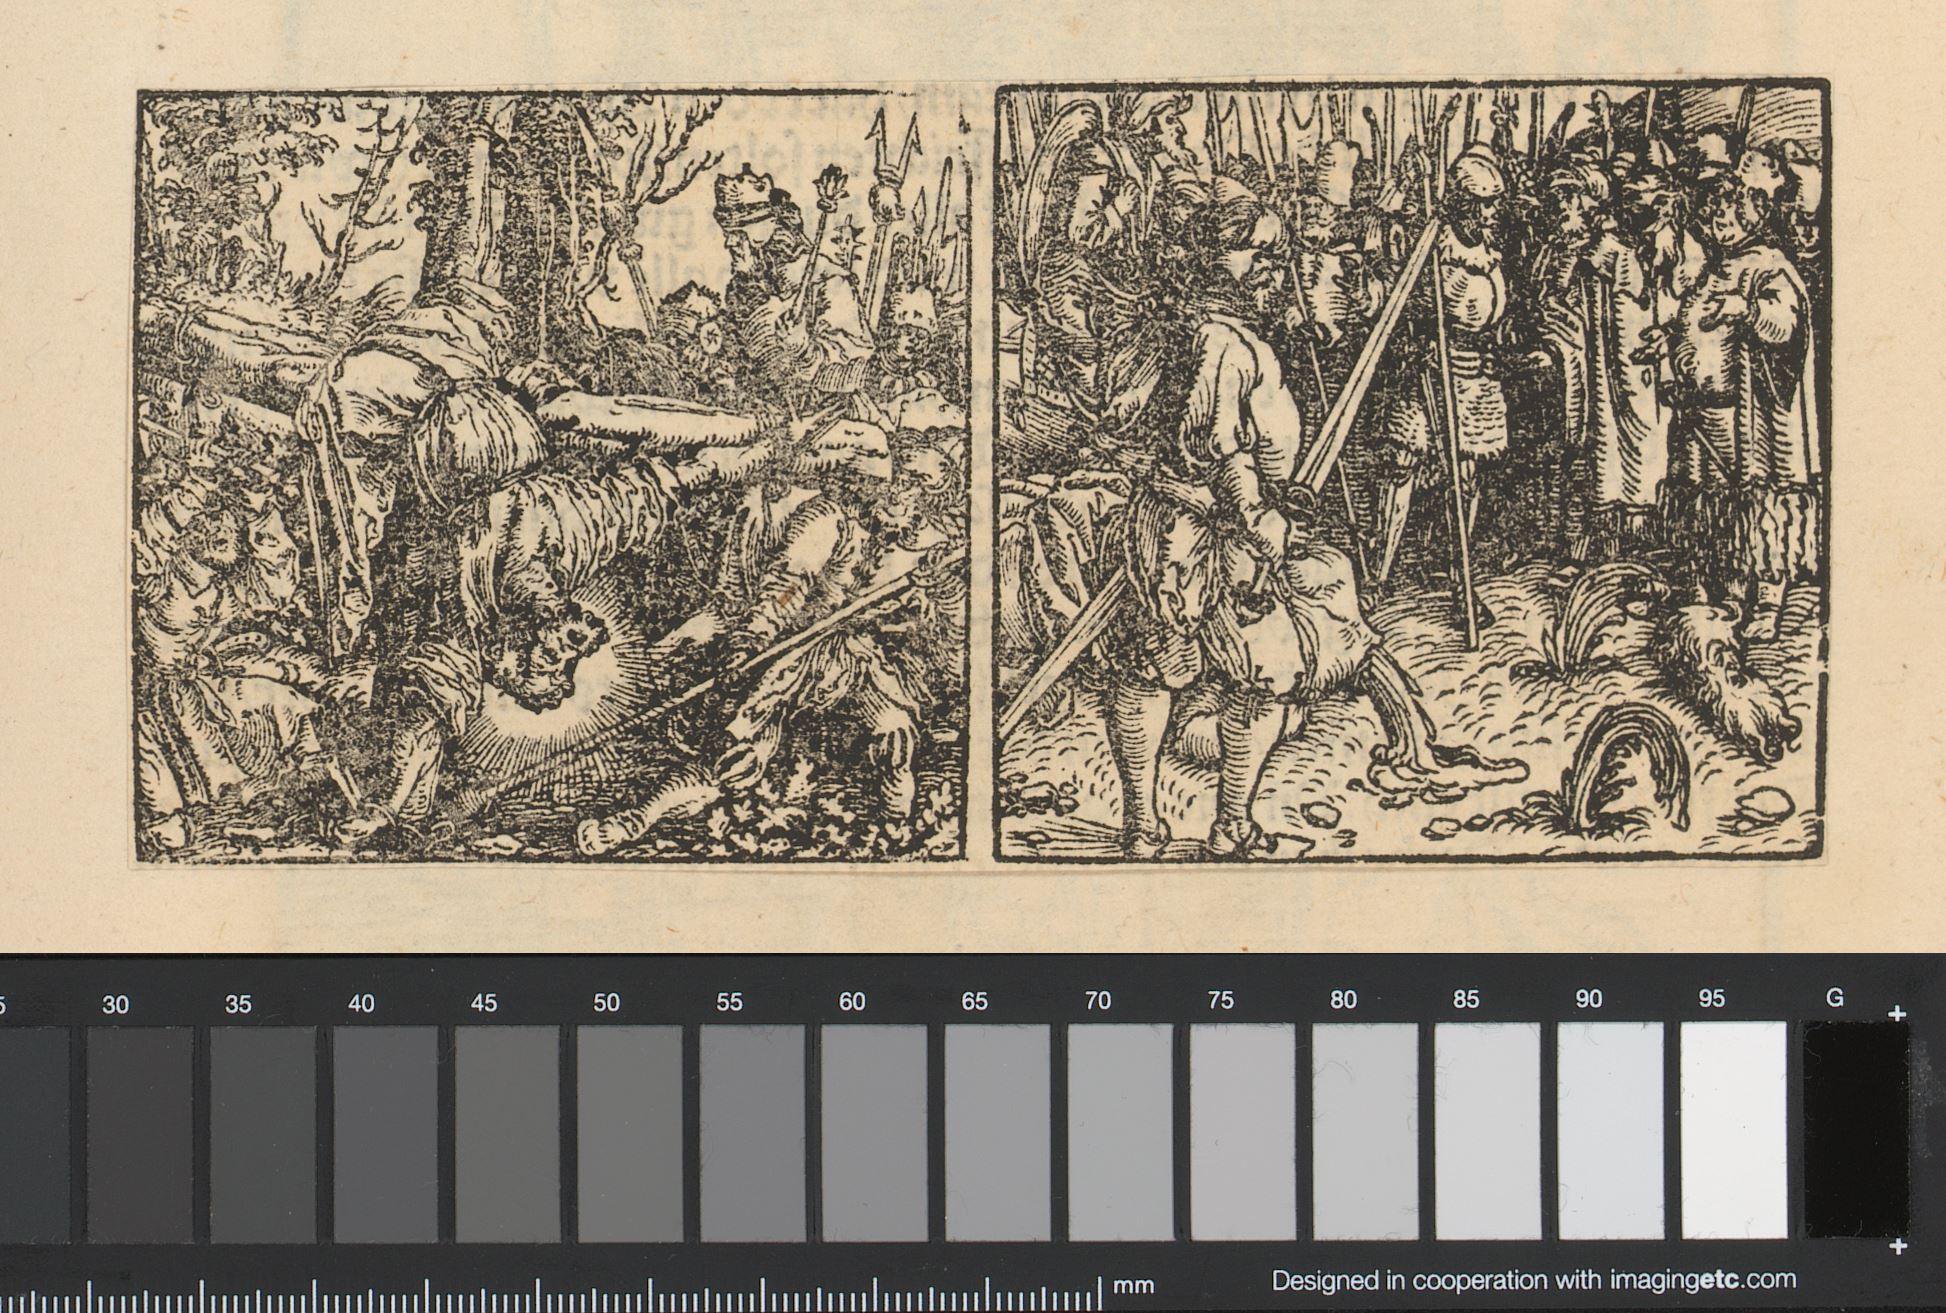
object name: album leaf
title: Kruisiging van Petrus en voorstelling van de onthoofding van de apostel Paulus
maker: Anonymous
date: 1514-1532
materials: paper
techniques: letterpress printing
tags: peter crucified upside down, the beheading of paul; maybe three fountains spring from his head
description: Deze prent is gebruikt in: Petrarca, Francesco. Von der Artzney bayder Glück, des guten und widerwertigen: unnd weß sich ain yeder inn Gelück und Unglück halten sol (...). Augsburg: Heinrich Steiner, 1532. Deze uitgave is ook bekend onder de titel 'Trostspiegel in Glück und Unglück'.